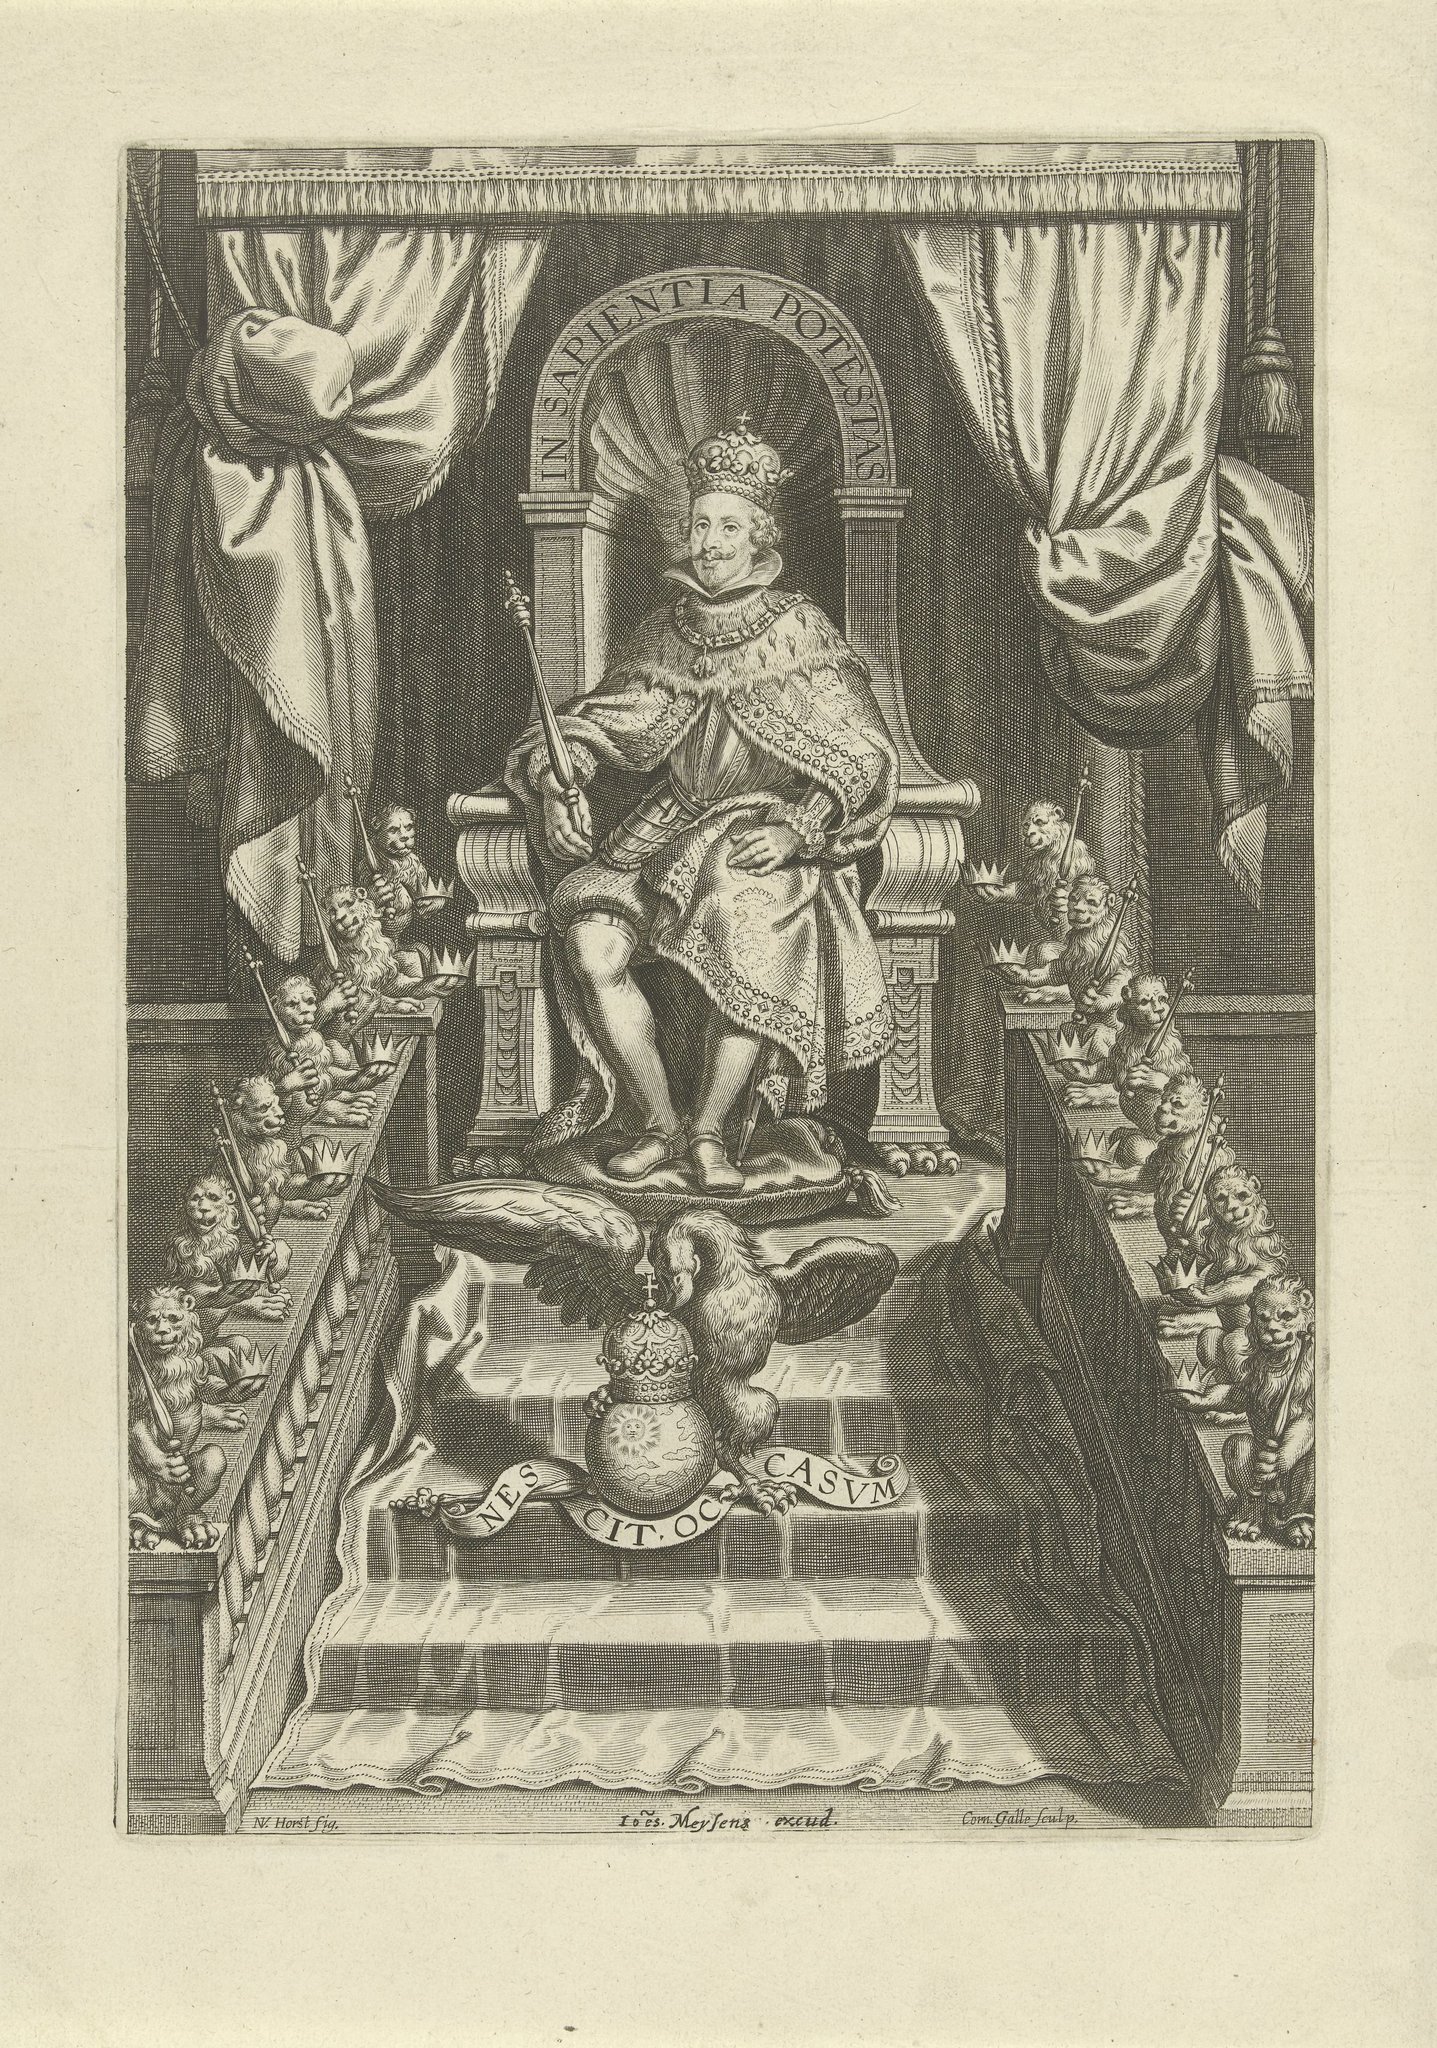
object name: print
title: Portret van Filips IV, koning van Spanje, ca. 1634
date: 1634-1670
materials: paper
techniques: engraving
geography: southern netherlands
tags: filips iv (koning van spanje)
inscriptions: collector's mark: Lugt 2228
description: Deze prent is volgens M. Mauquoy-Hendrickx (Le Livre et l'Estampe 1955, nr. 3, pp. 23-26) ten onrechte door Muller ingedeeld in het jaar 1648 bij de prenten rond de Vrede van Munster. Het portret is namelijk al gebruikt als frontispice bij een reeks portretten naar Van Dyck uitgegeven door Jean Pepermans in 1634.